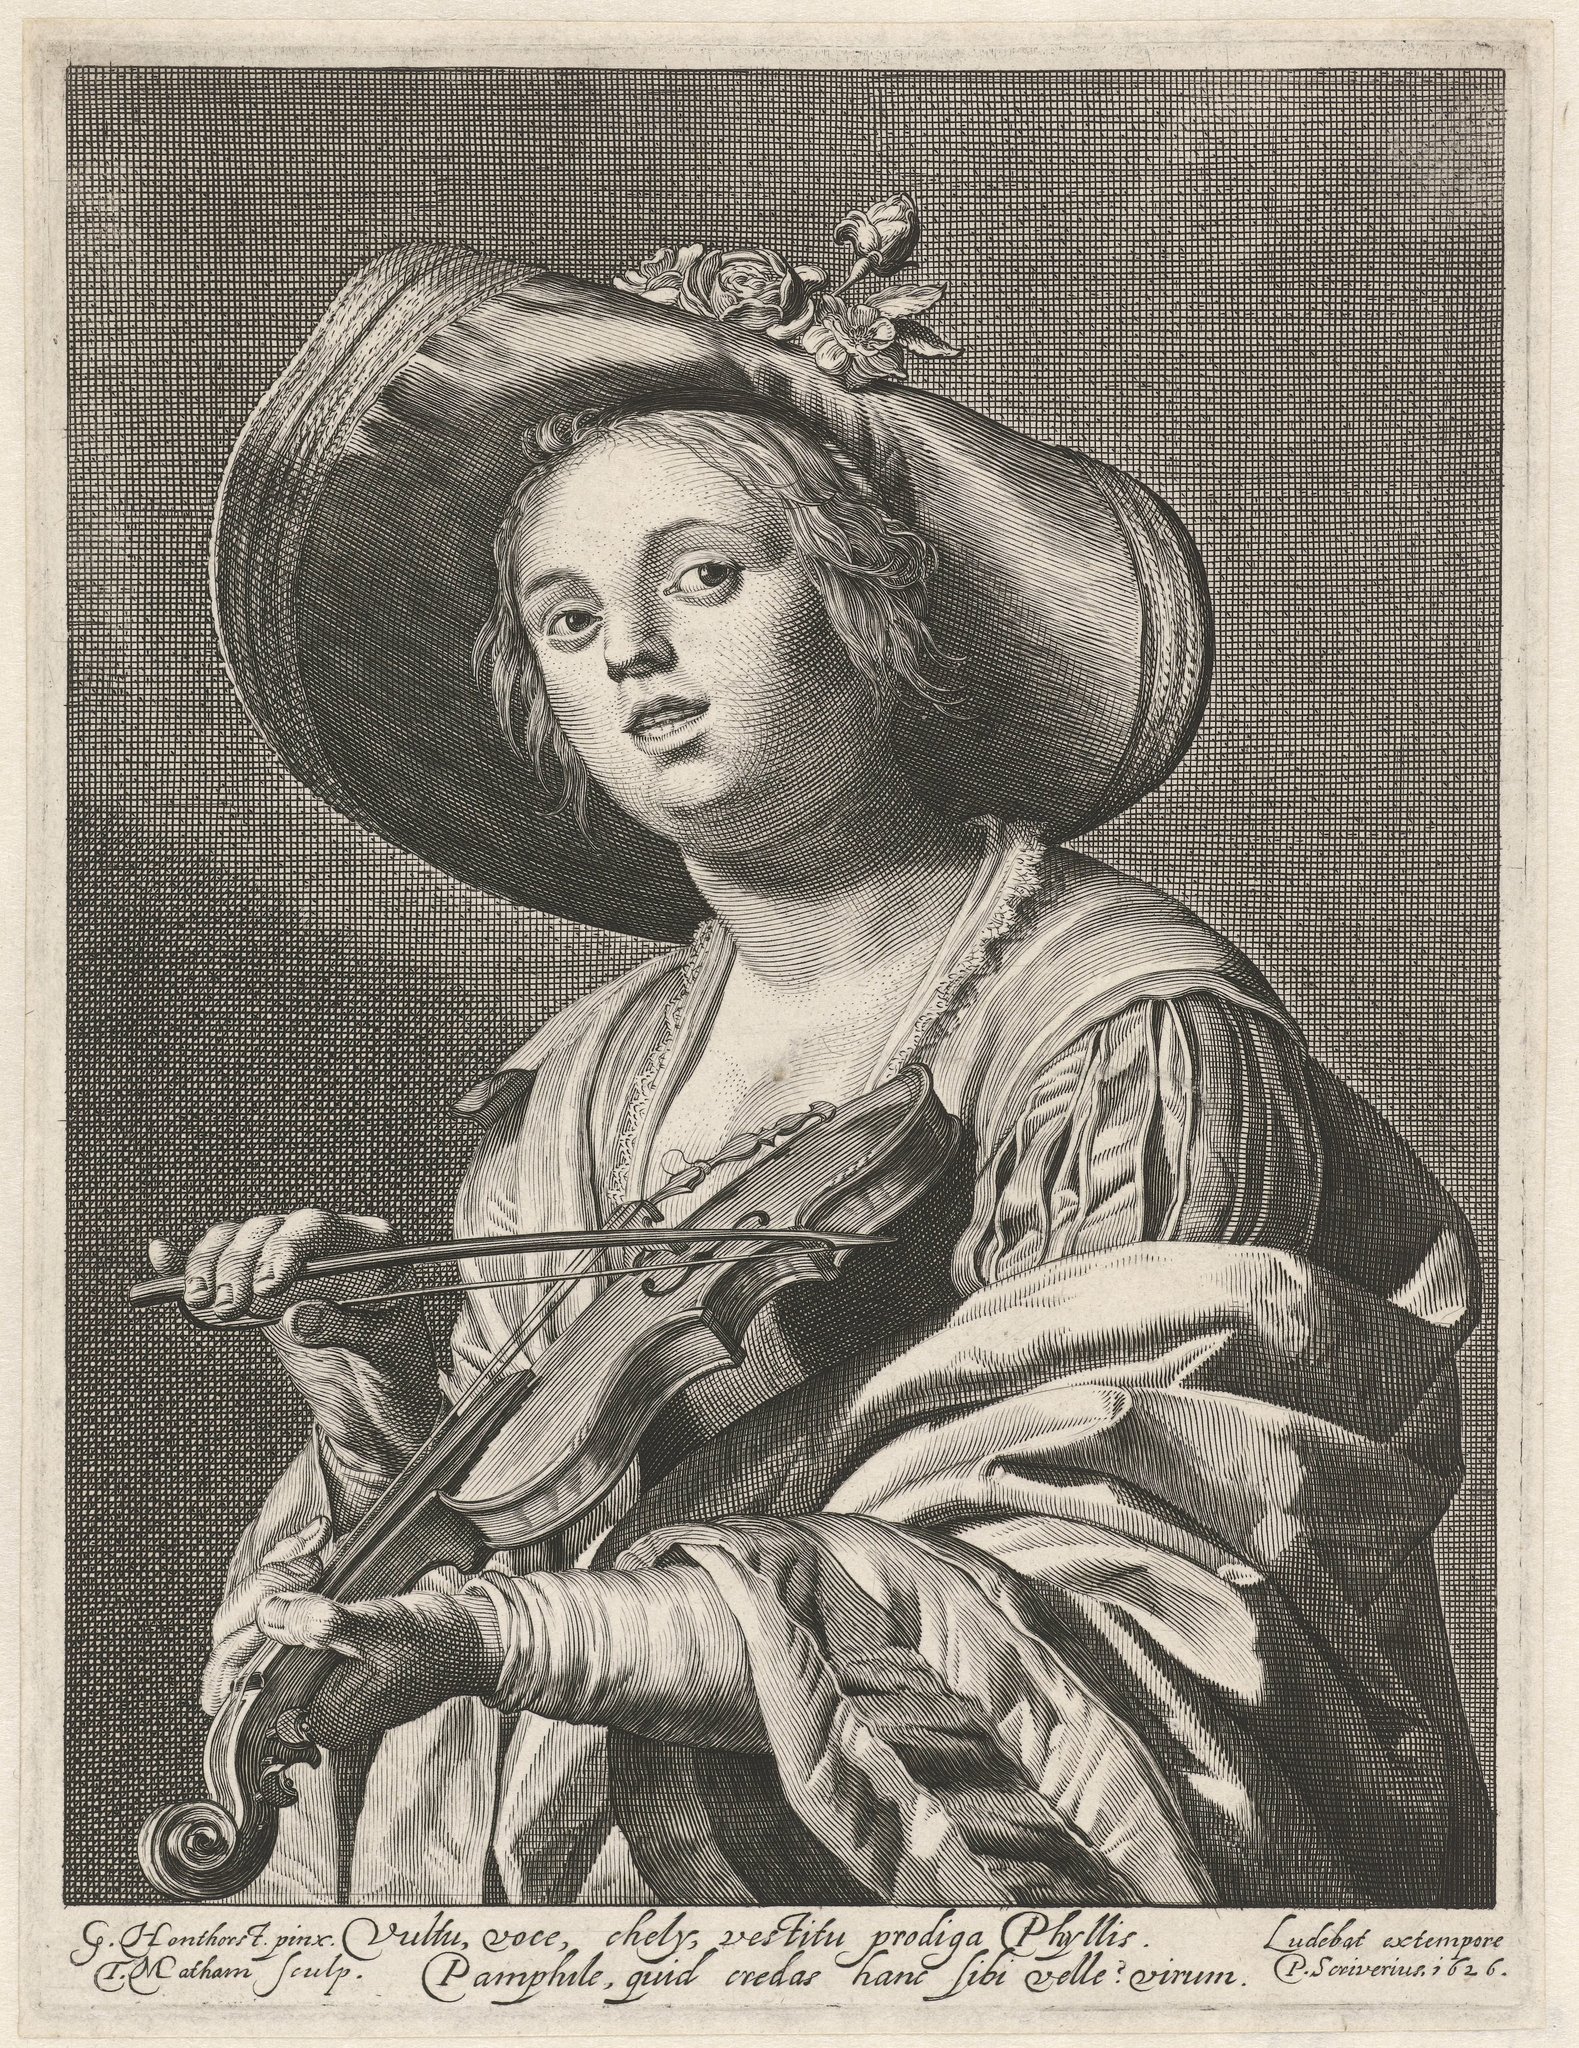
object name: print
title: Vioolspelend meisje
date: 1626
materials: paper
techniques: engraving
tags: adolescent, young woman, maiden, violin, fiddle, head-gear: hat (+ women's clothes), one person playing an instrument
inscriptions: collector's mark: Lugt 240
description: Een meisje speelt op een viool. Op het hoofd draagt zij een hoed met een roos. Het onderschrift identificeert haar als de verleidelijke Phyllis.